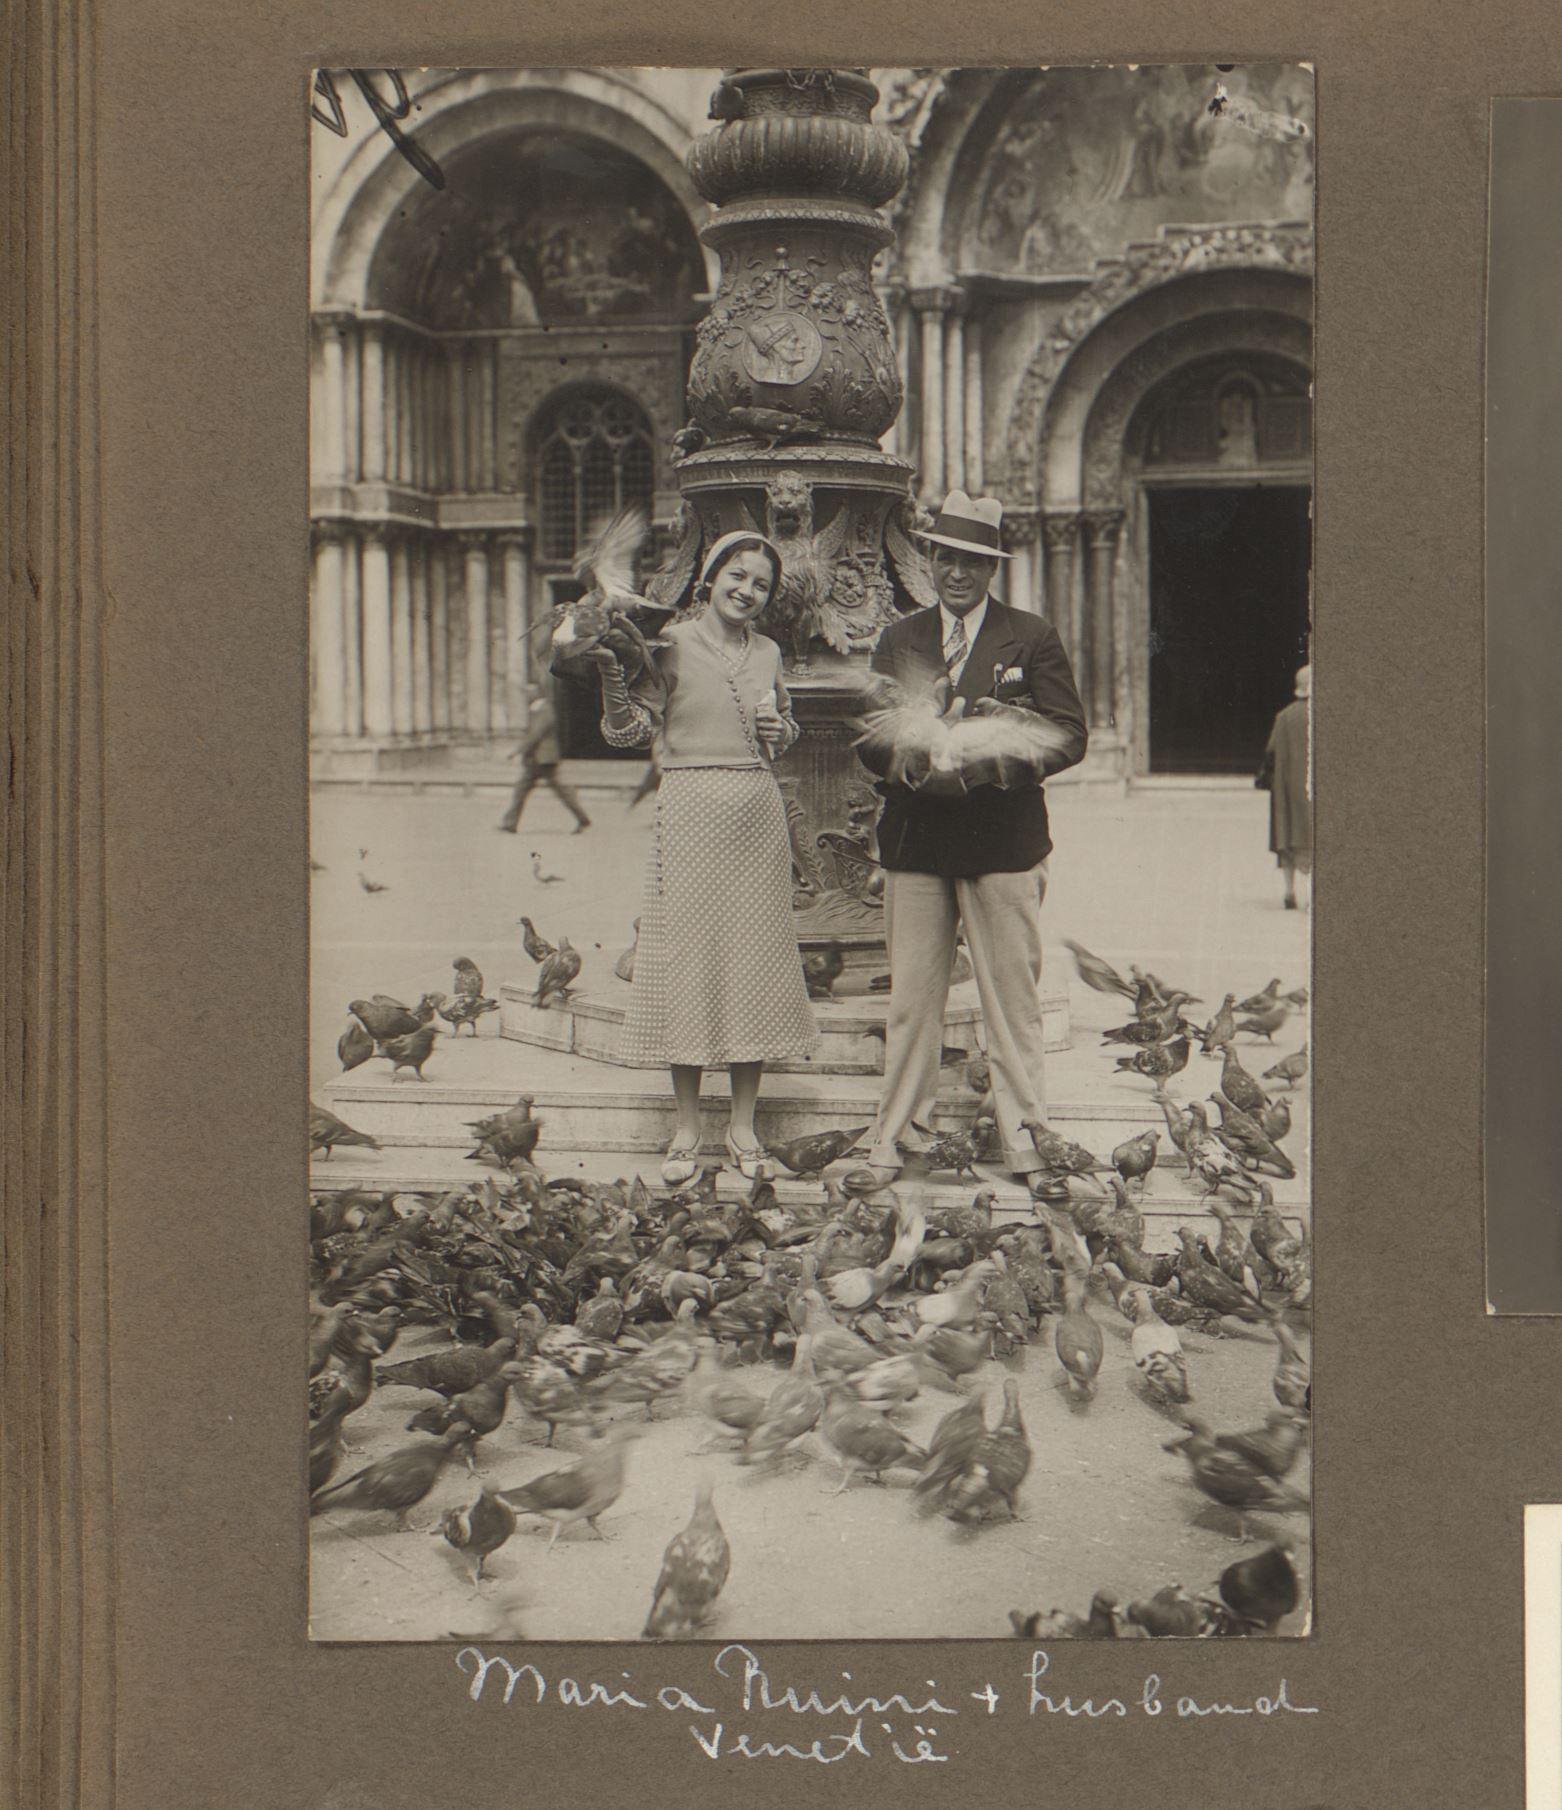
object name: photograph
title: Maria Ruini en haar echtgenoot met duiven op het San Marcoplein, Venetië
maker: Anonymous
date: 1932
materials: paper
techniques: gelatin silver print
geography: venice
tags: square, place, circus, etc., doves, pigeons, historical persons not known by name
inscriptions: inscription: ‘Maria Ruini +husband/ Venetië’